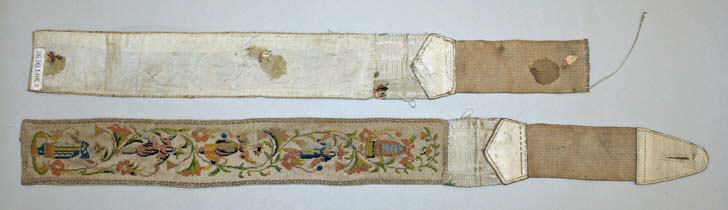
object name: suspender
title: Suspenders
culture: european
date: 1801-1900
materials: silk